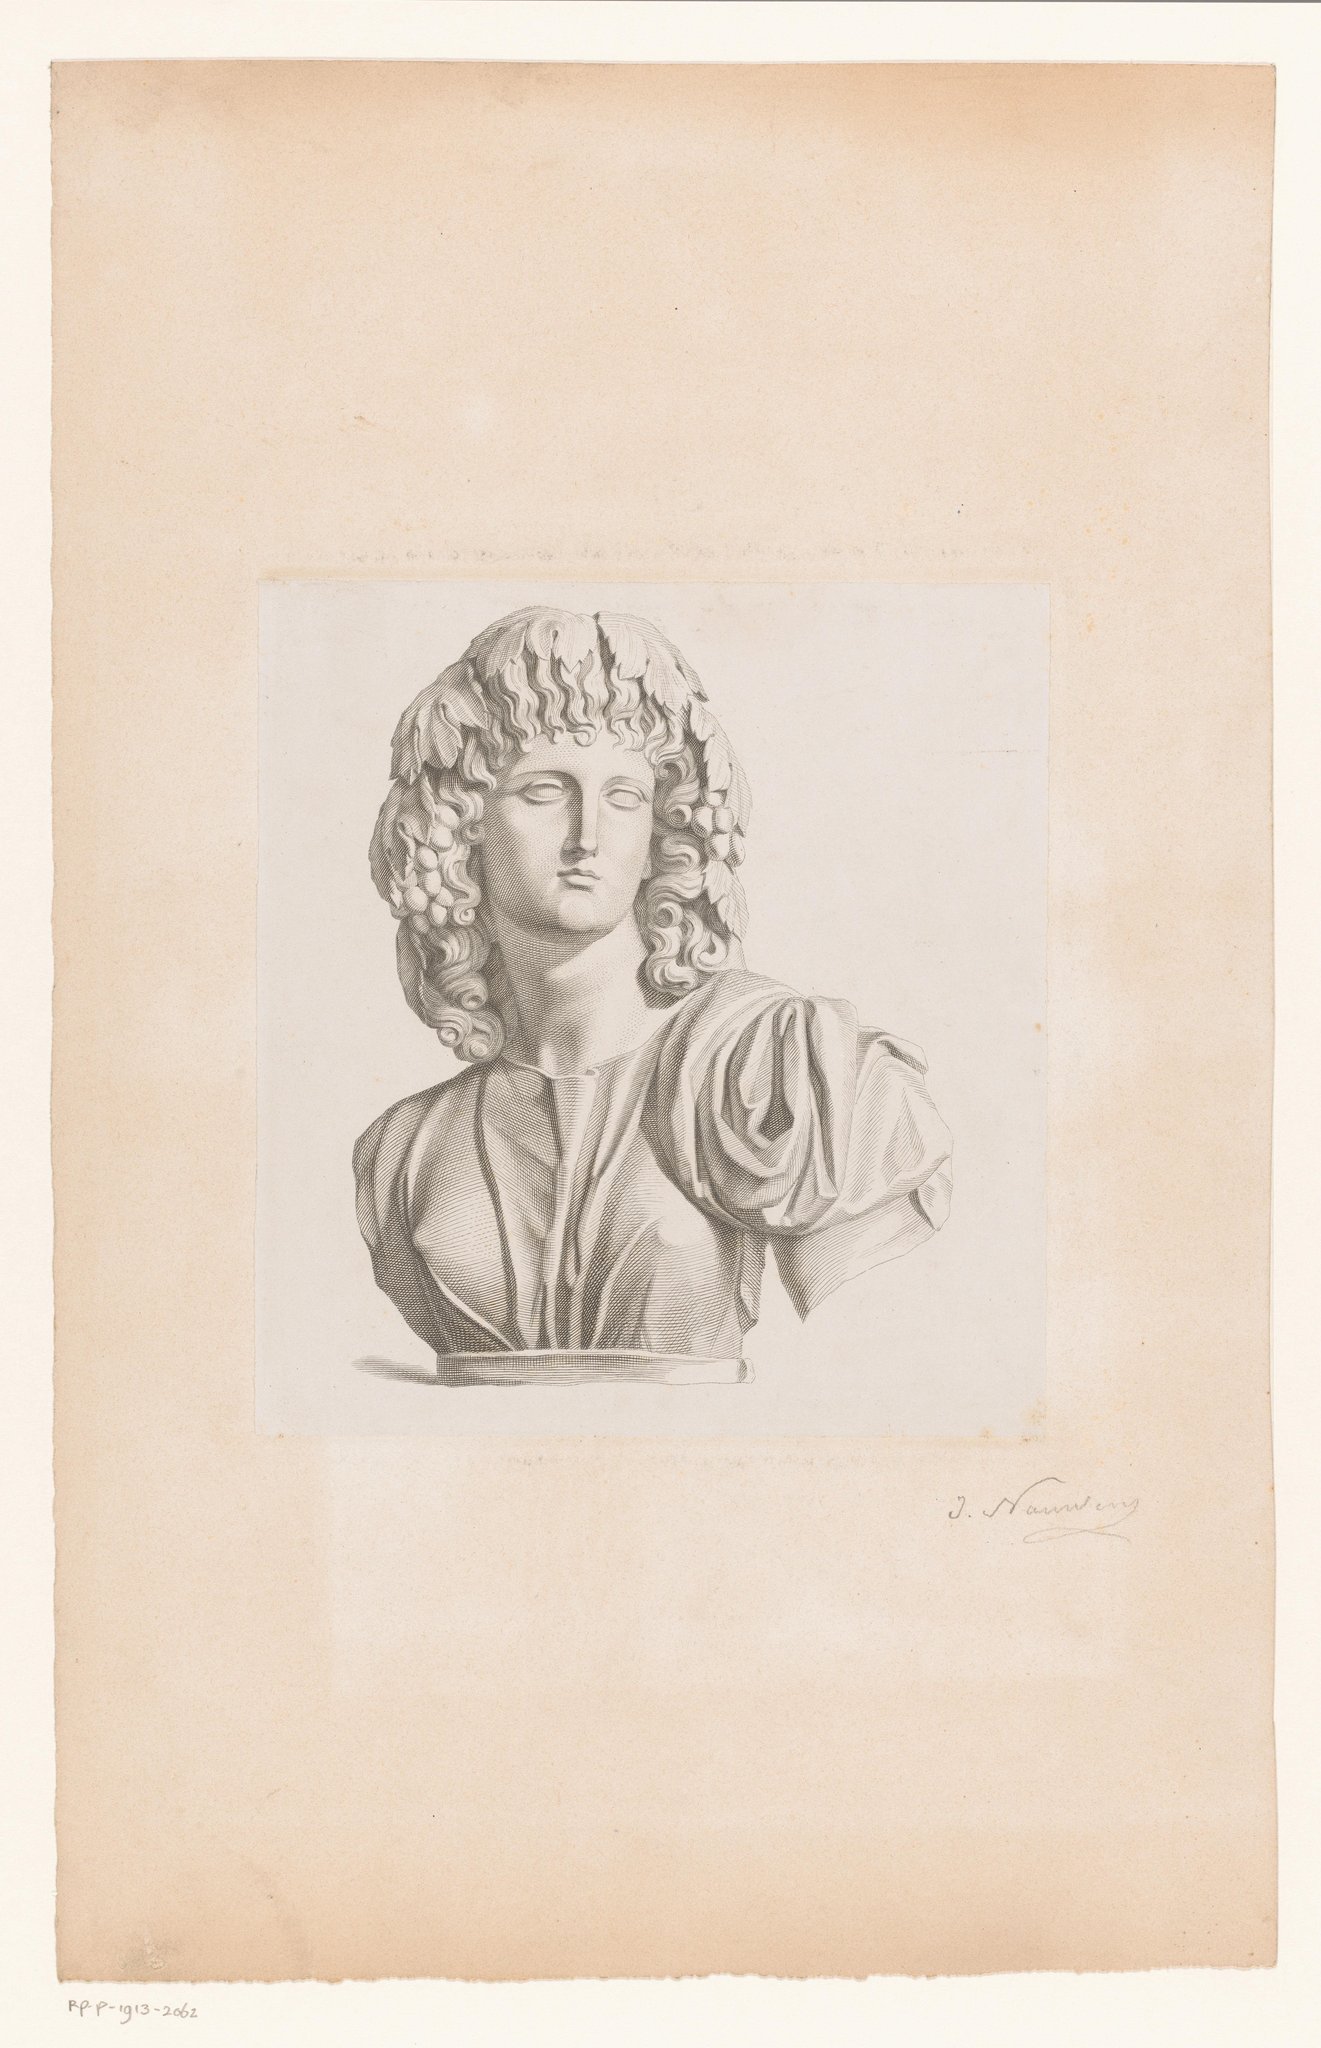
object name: print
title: Buste van een vrouw met wijnbladeren en druiven in het haar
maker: josephus nauwens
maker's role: print maker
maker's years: 1830-1906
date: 1840-1886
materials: paper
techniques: engraving, etching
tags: vine-tendril, leaf, piece of sculpture, reproduction of a piece of sculpture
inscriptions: collector's mark: Lugt 2228